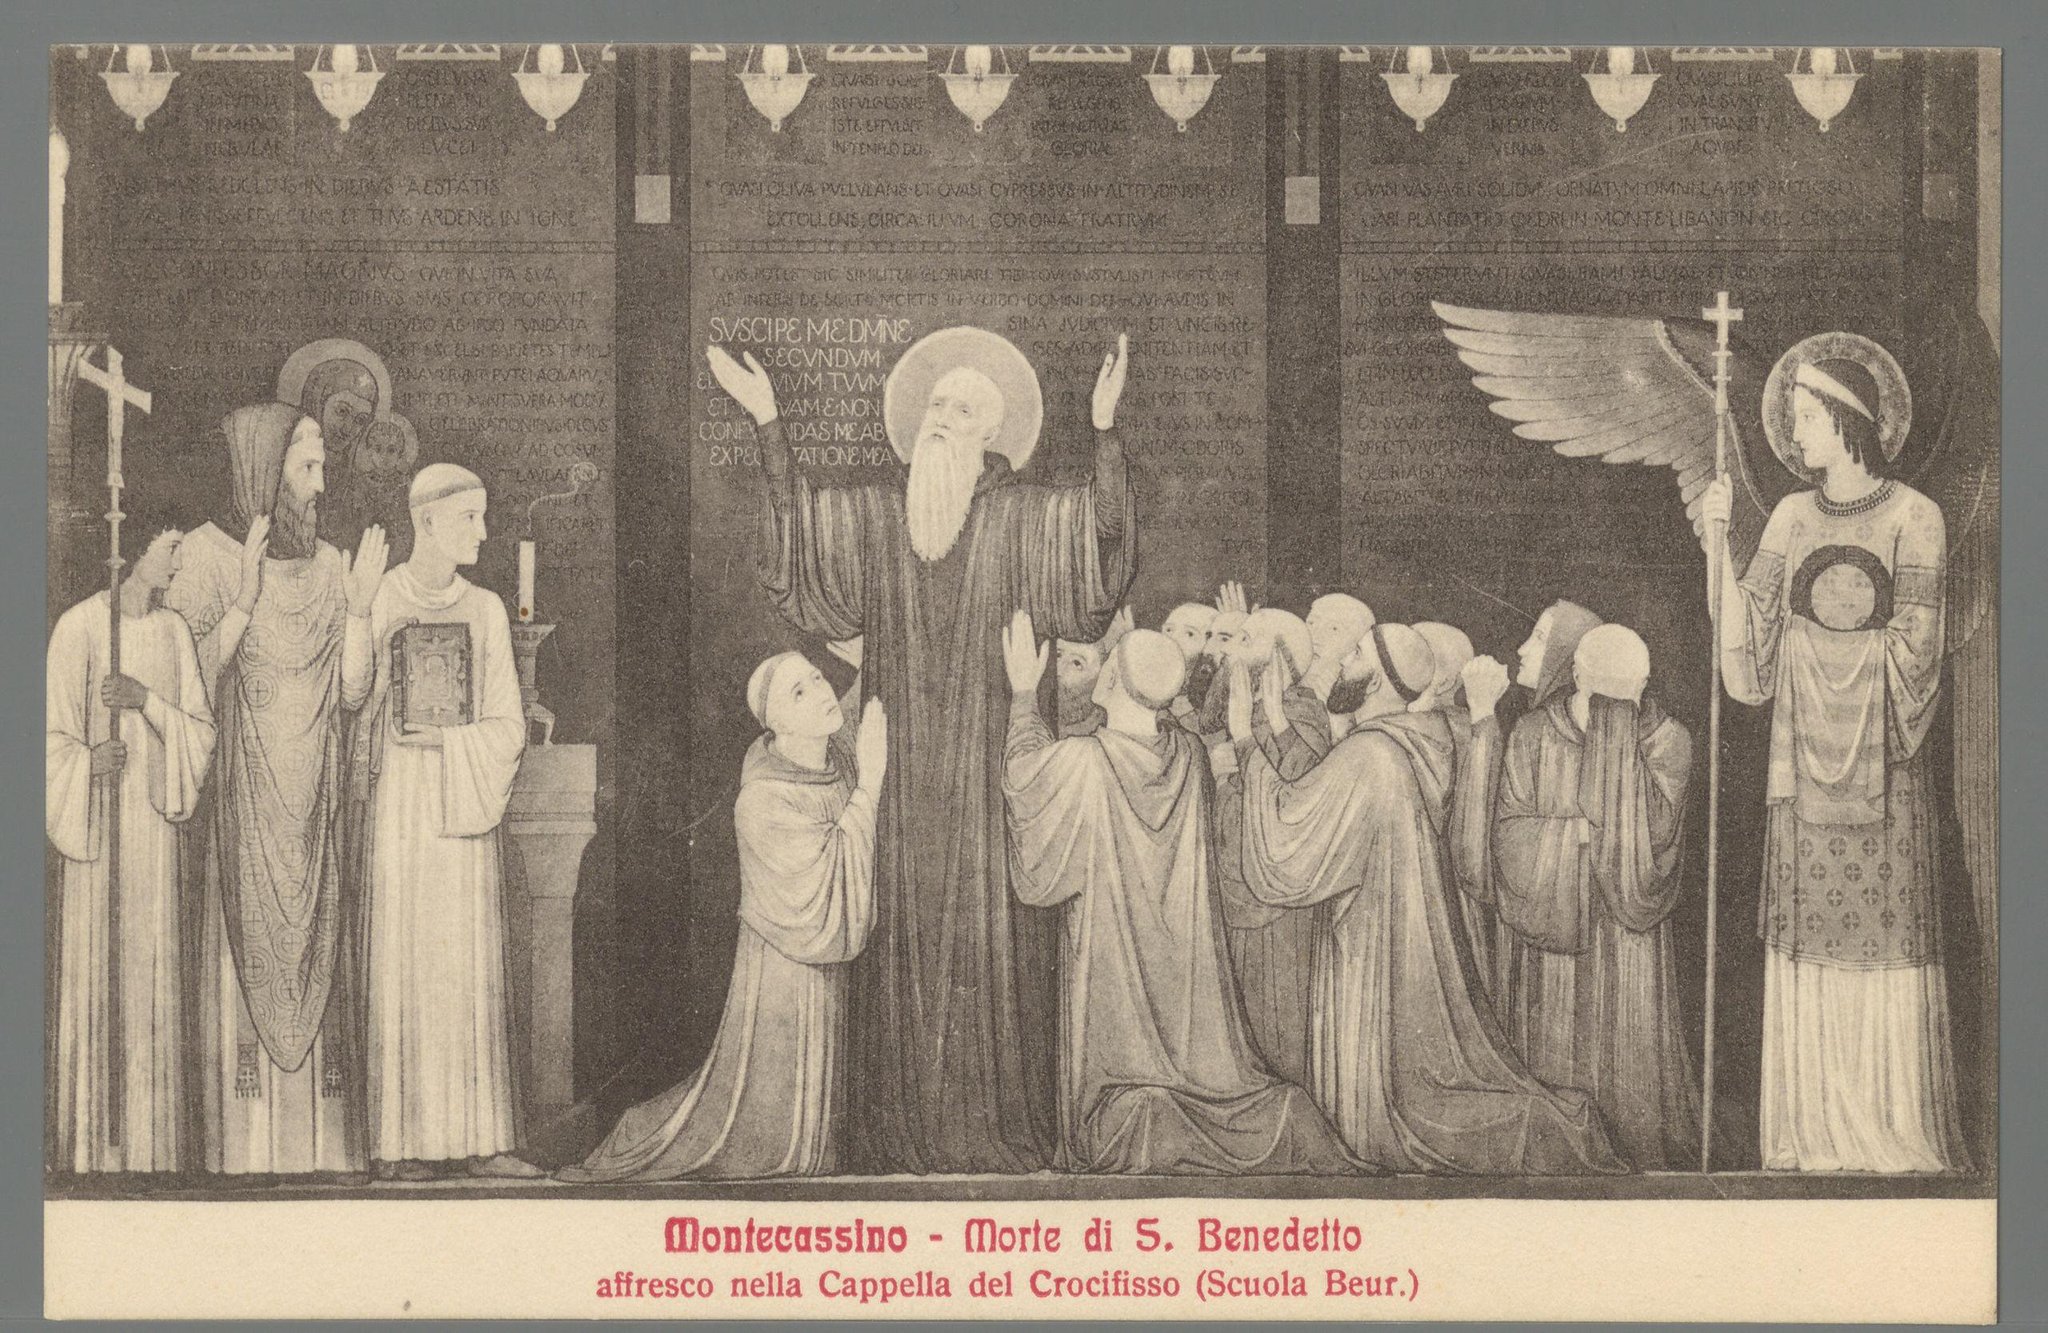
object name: ansichtkaart, prentbriefkaart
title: Montecassino. Morte di S. Benedetto. Affresco nella Cappella del Crocifisso (Scuola Beur.)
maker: Anonymous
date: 1906-1910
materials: cardboard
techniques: photograph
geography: terni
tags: interior of church, picture, painting